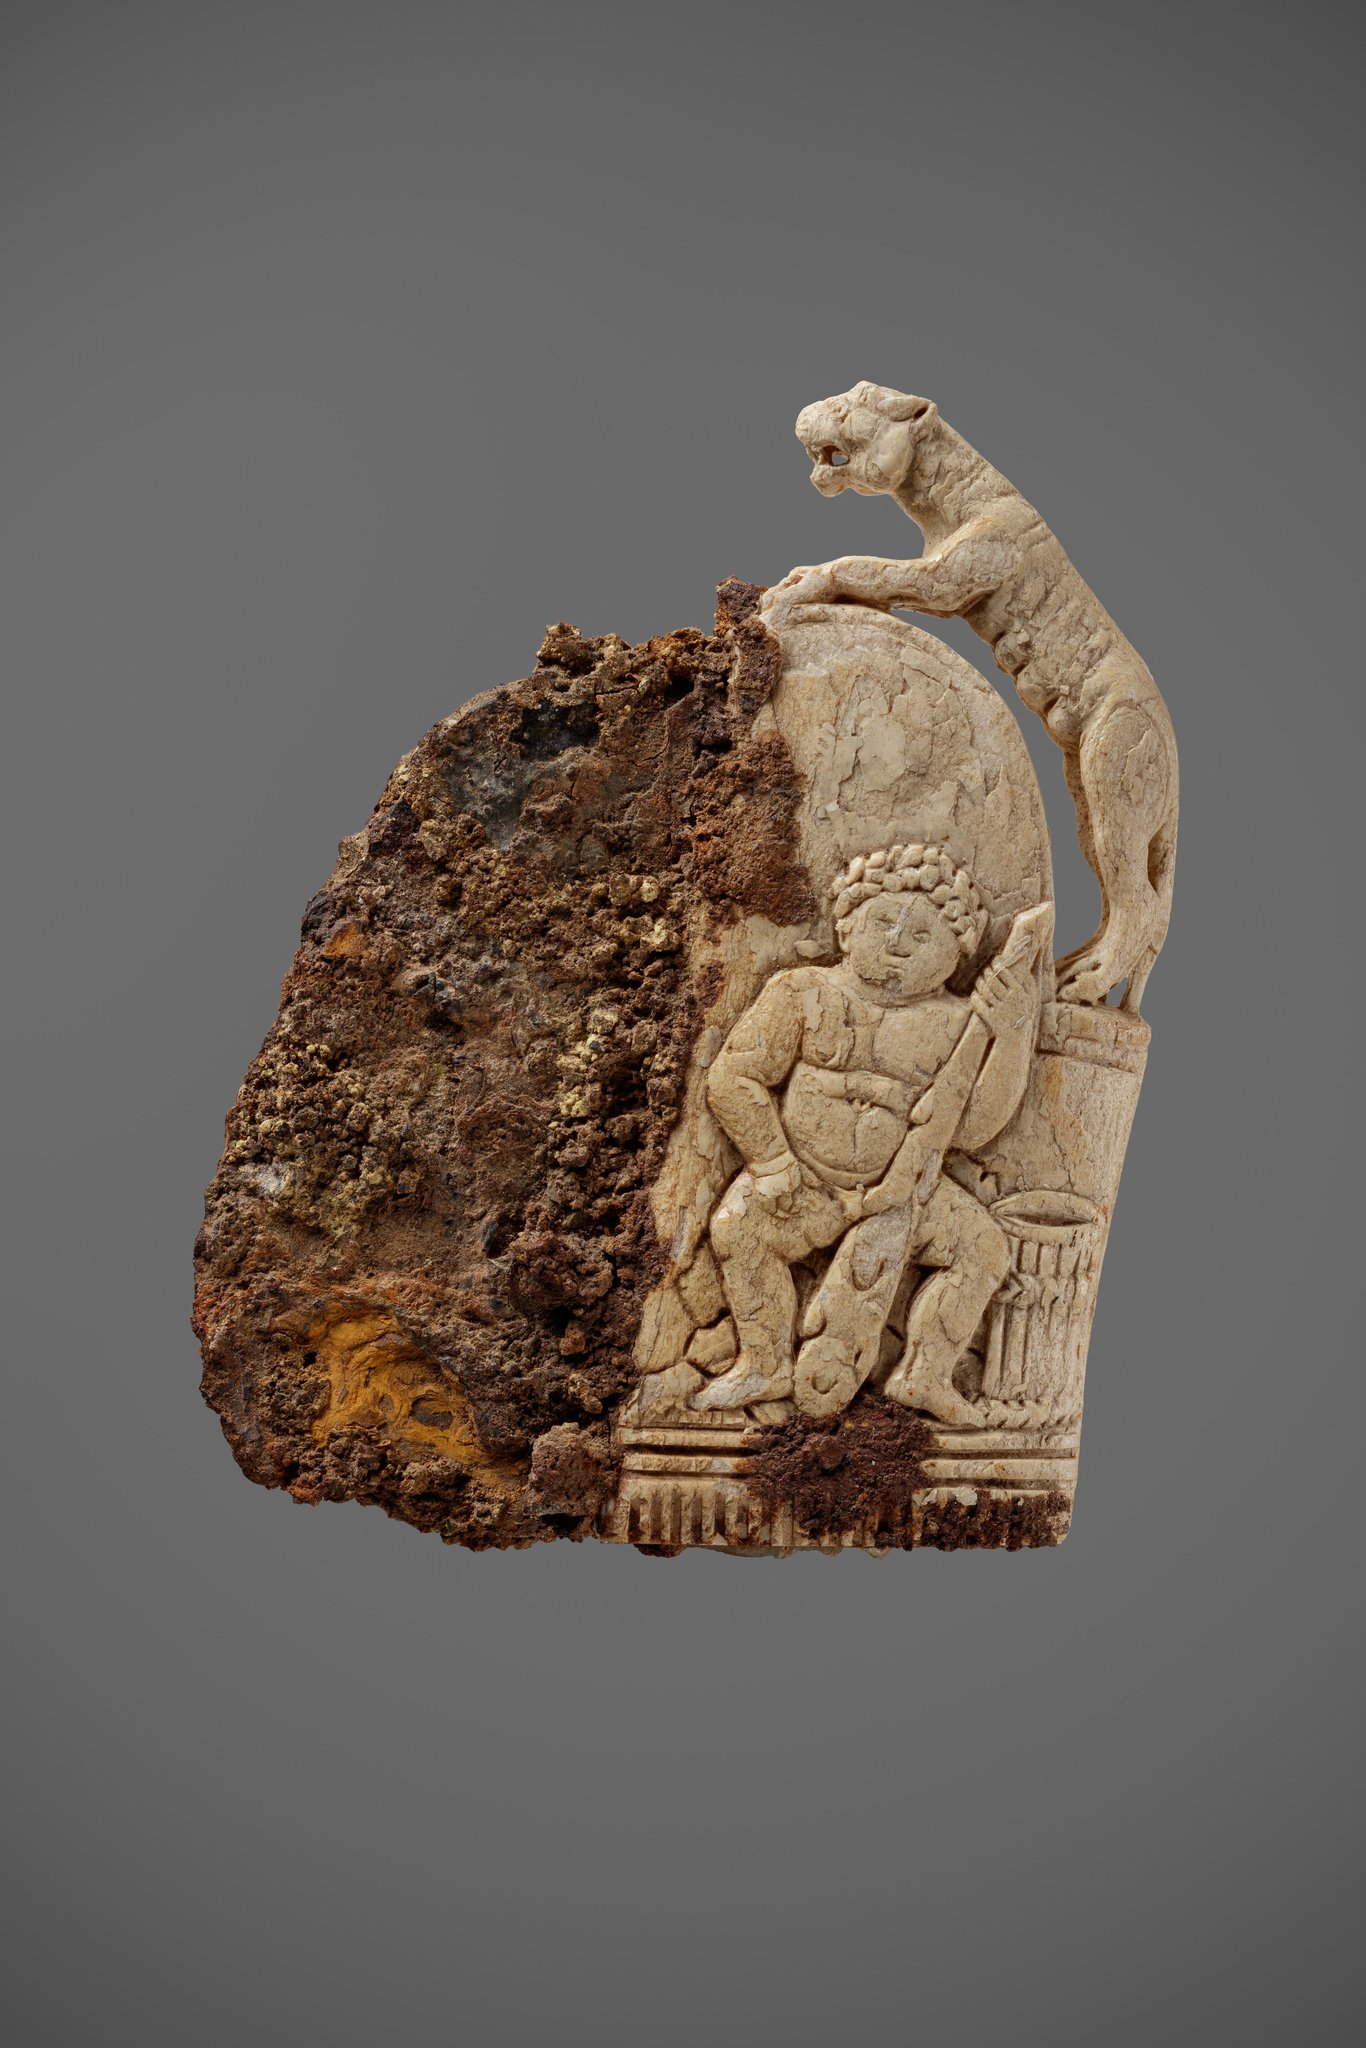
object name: knife or razor handle, herakles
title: Iron Razor or Folding Knife with Ivory Handle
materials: iron, ivory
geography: egypt or italy